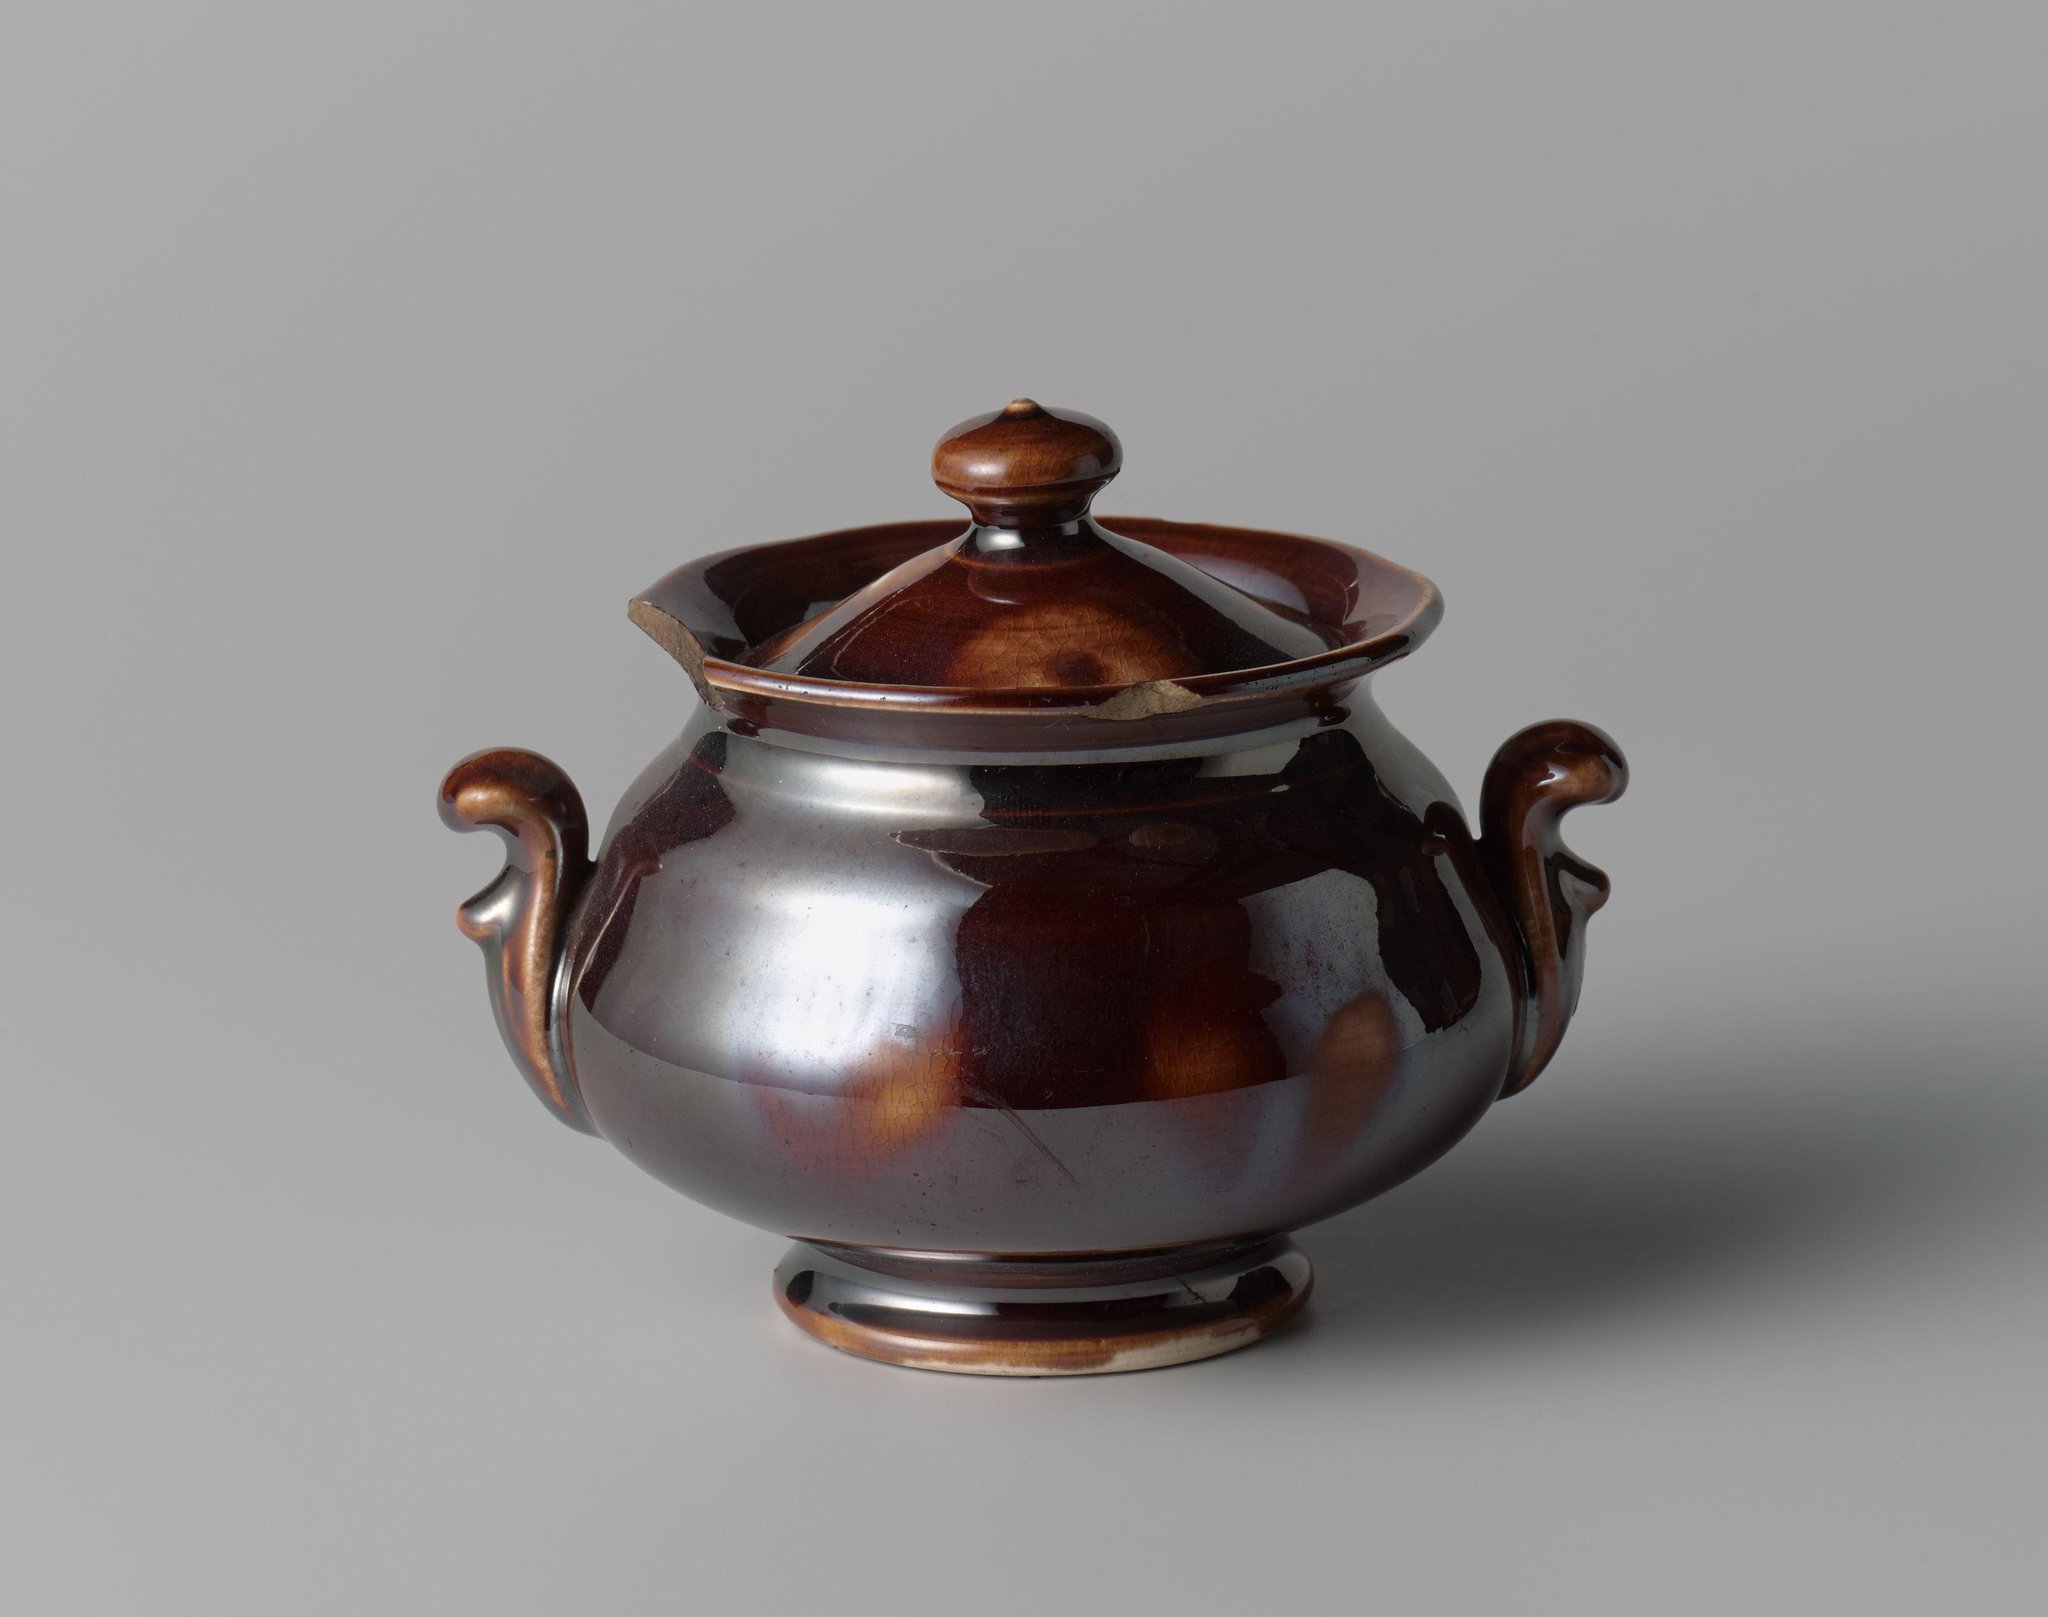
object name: lid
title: Deksel, bruin met lichte vlekken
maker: petrus regout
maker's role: plateelbakker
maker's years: 1801-1879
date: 1801-1879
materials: earthenware, glaze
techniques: vitrification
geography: maastricht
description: Deksel van aardewerk met bruine lusterglazuur. Op het deksel lichte vlekken.